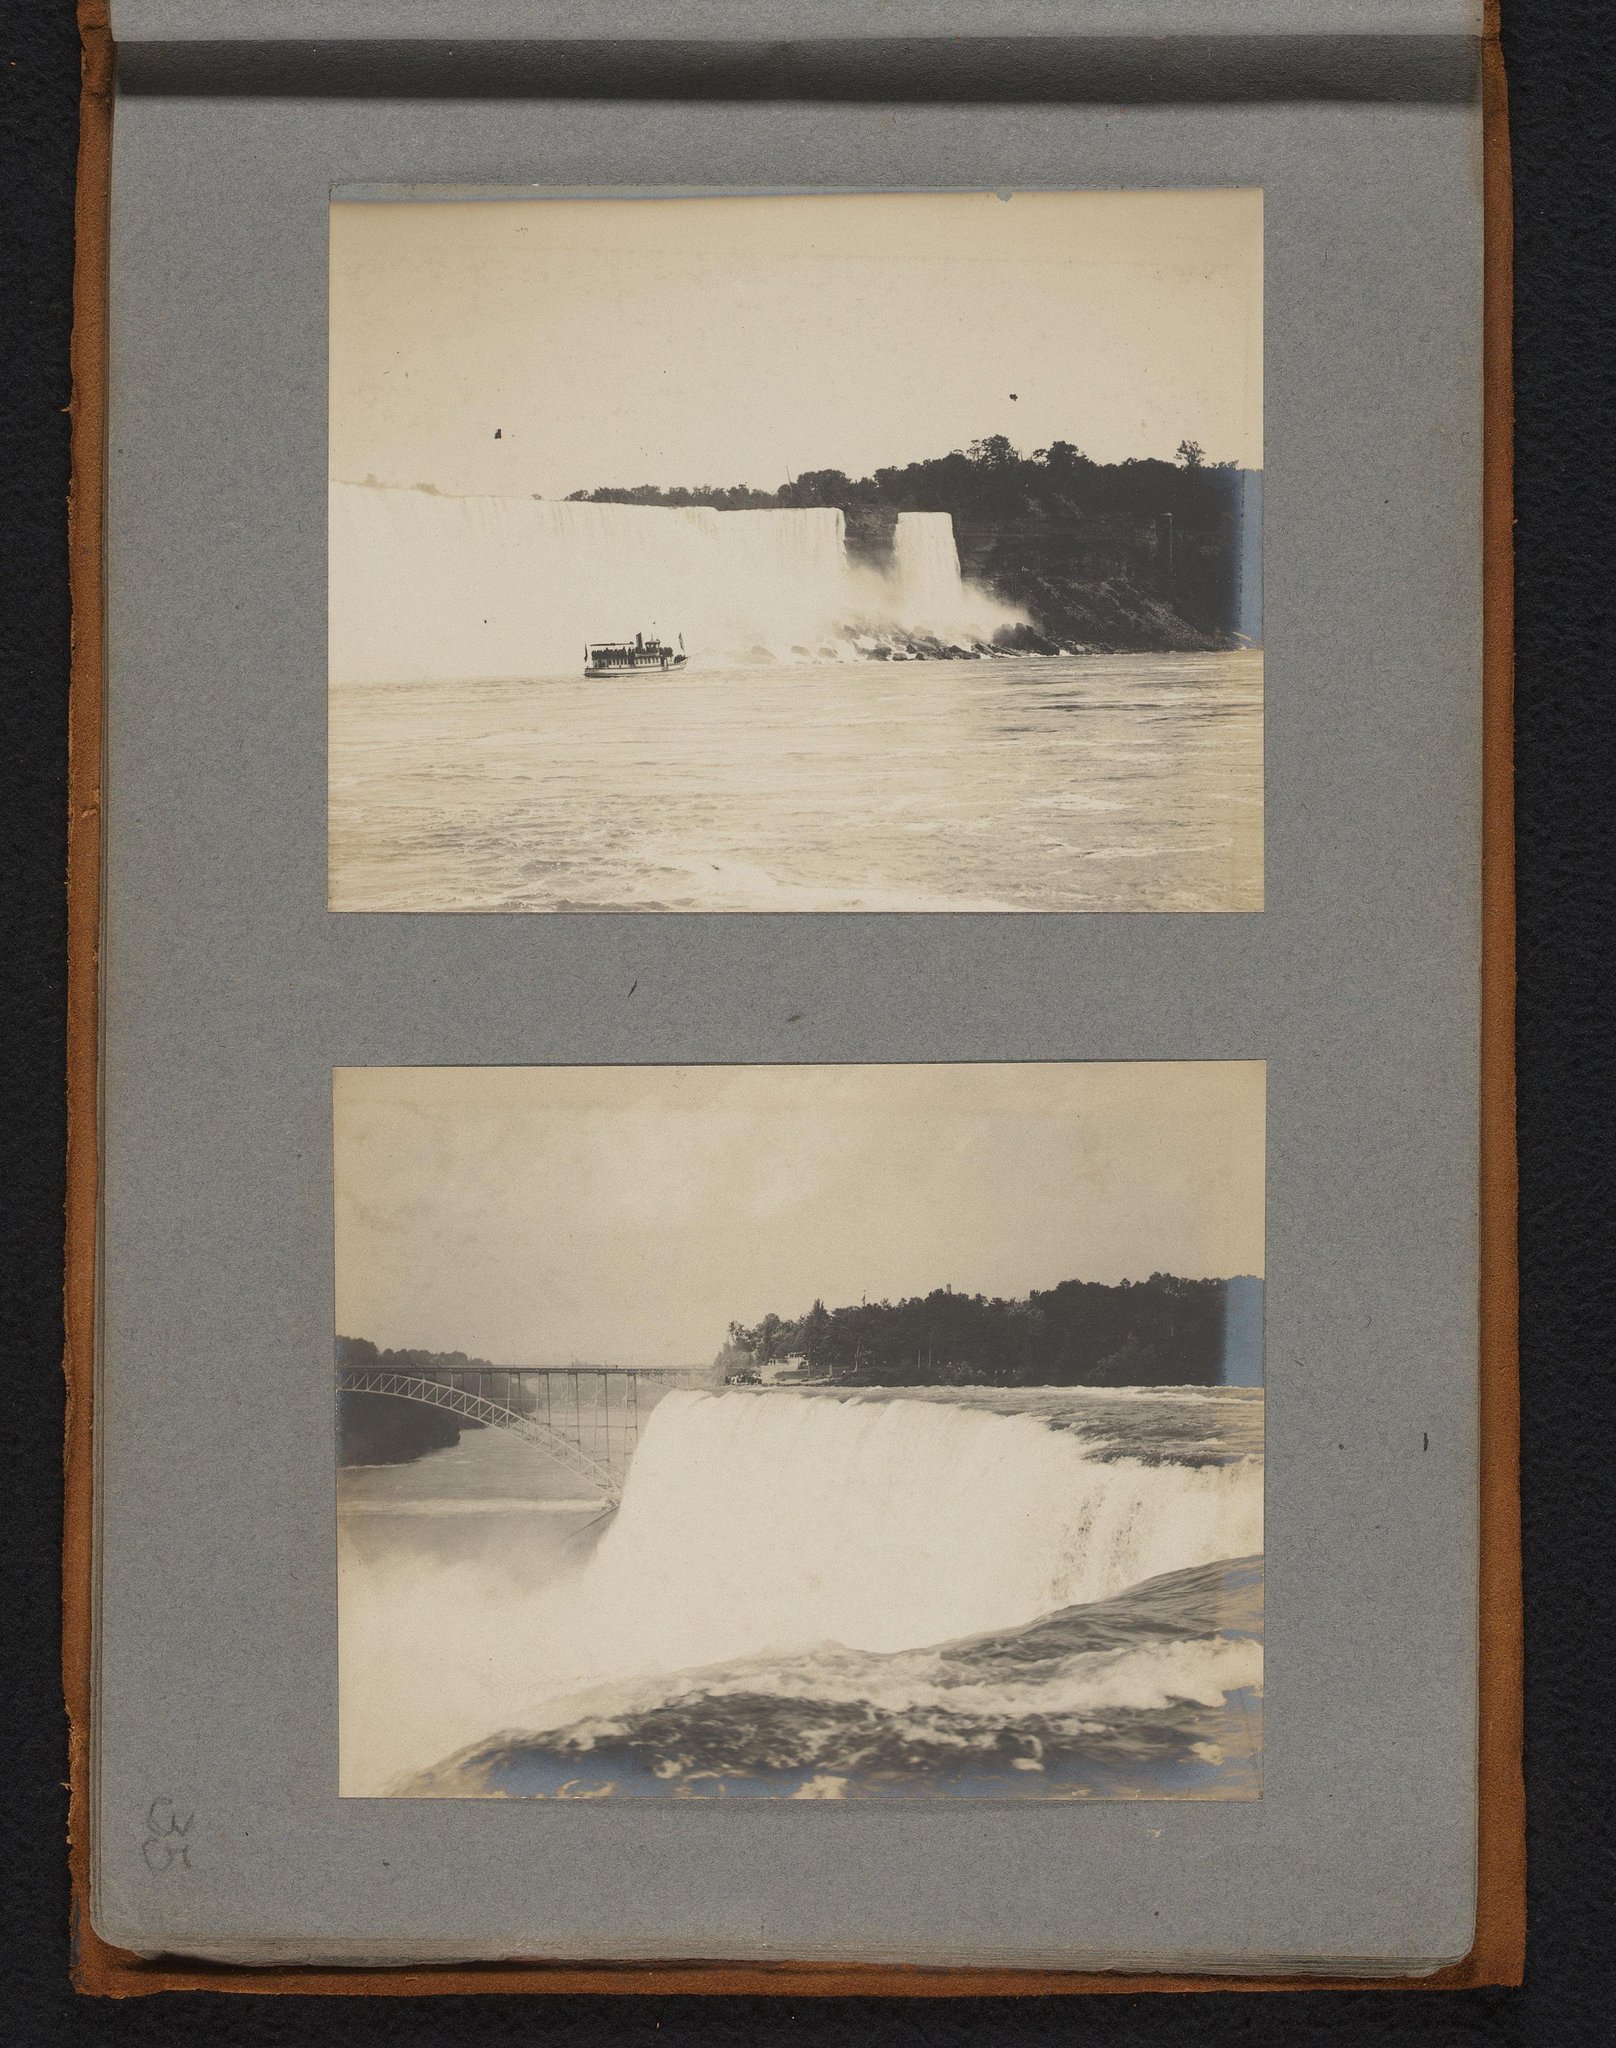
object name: album leaf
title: Gezicht op de Niagarawatervallen met een stoomboot en de voormalige Honeymoon Bridge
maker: jan van der mey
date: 1902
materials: paper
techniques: gelatin silver print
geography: niagara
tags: waterfall, landscape with bridge, viaduct or aqueduct, steamship, motorship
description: Deze foto's maken deel uit van een album.